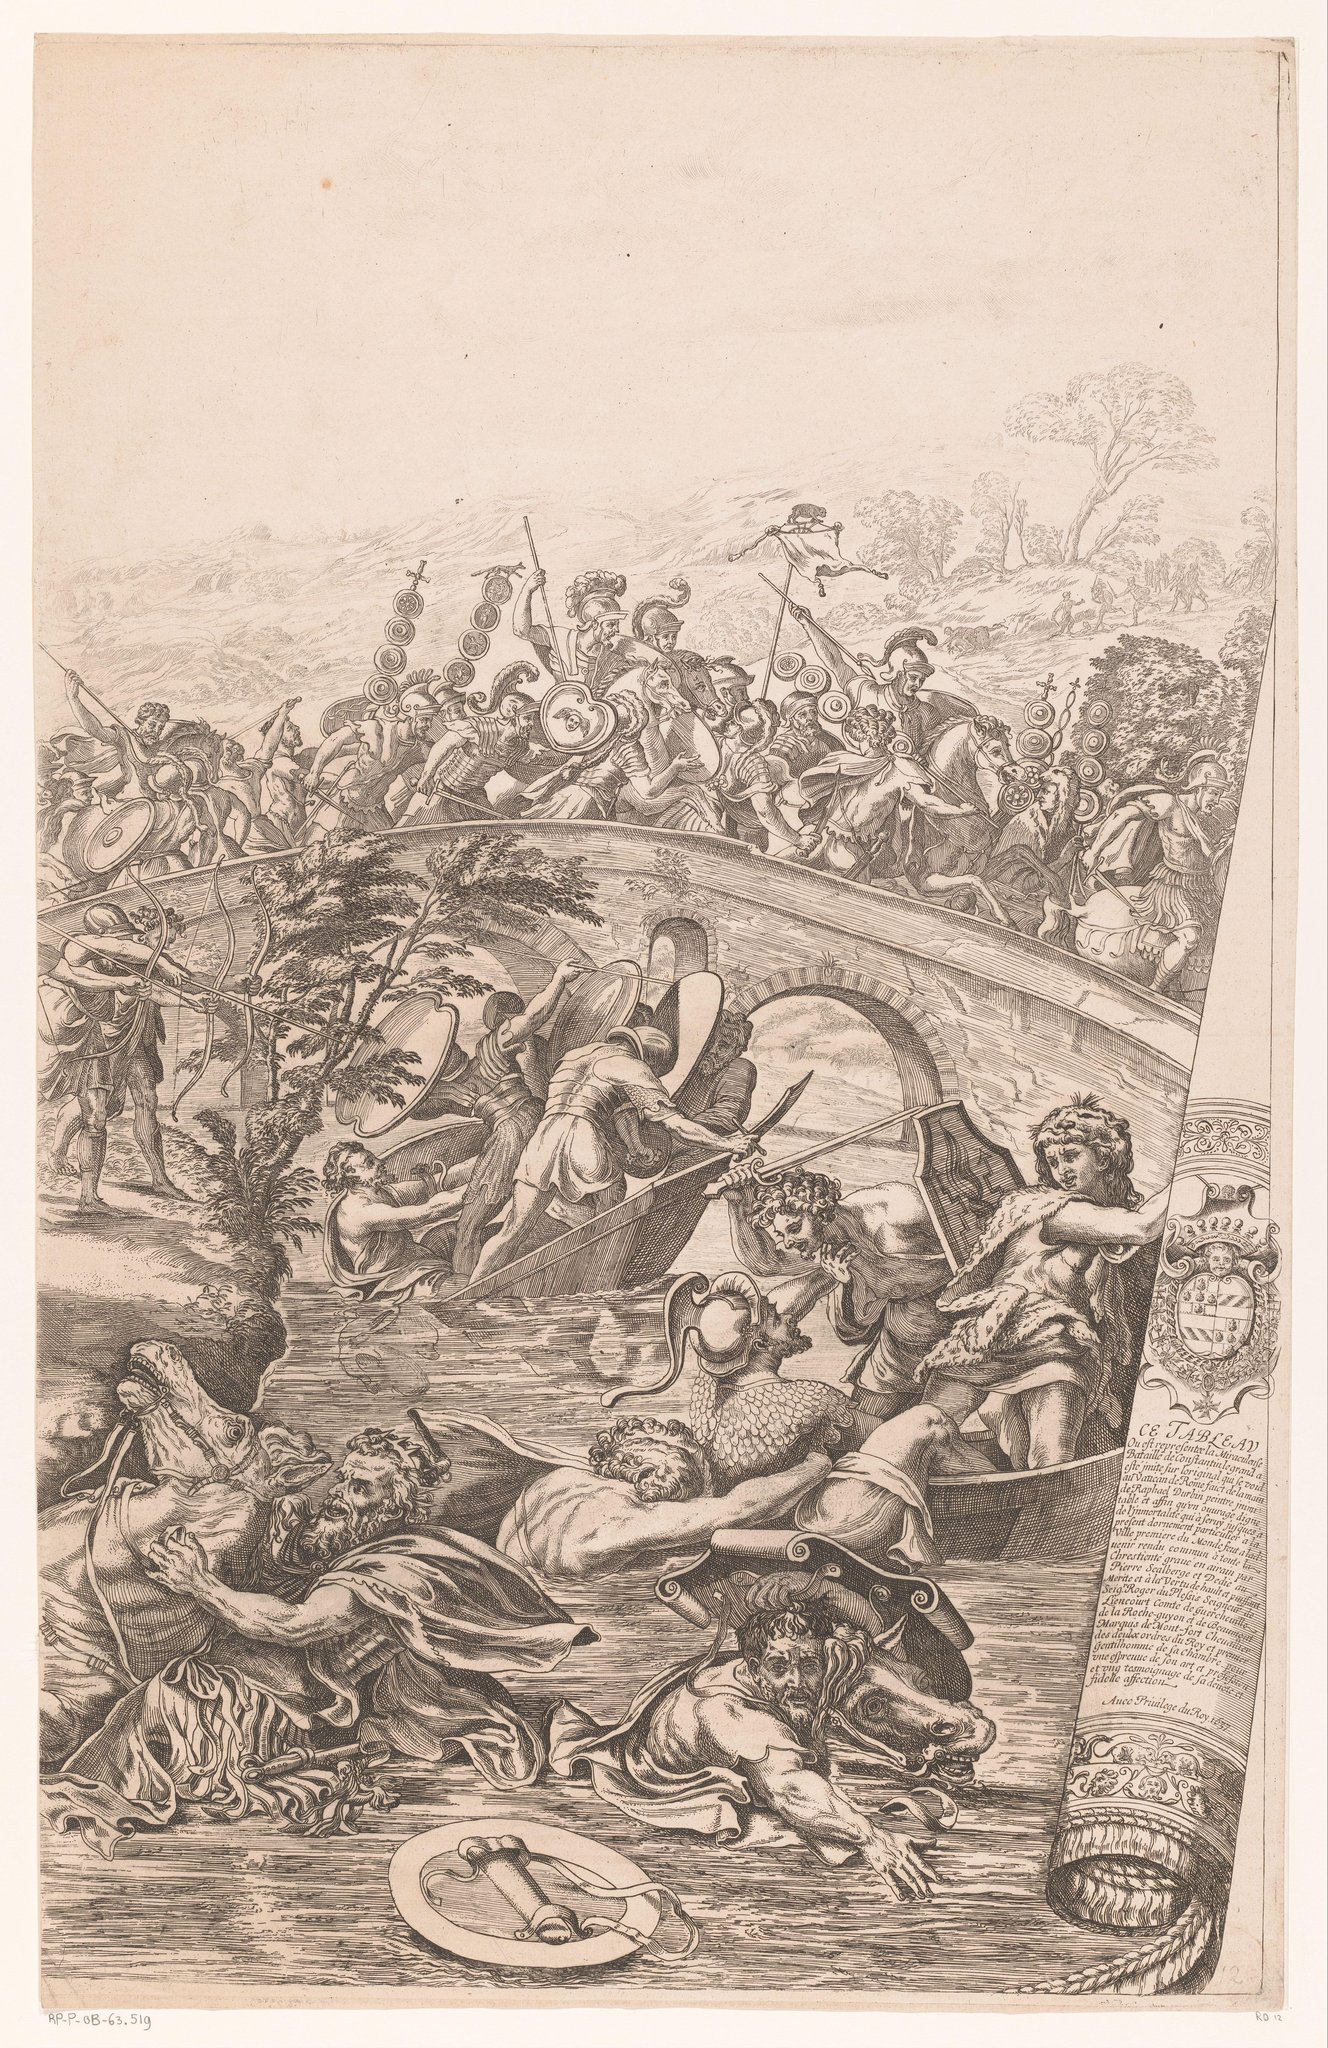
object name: print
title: Slag bij de Milvische brug (vierde deel)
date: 1637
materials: paper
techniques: etching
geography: france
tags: the battle of the milvian bridge (saxa rubra): st. constantine on horseback confronts maxentius; a cross appears in the sky with in fiery letters 'in hoc signo vinces' (the raised standards of the roman soldiers carry a cross or the chi-rho monogram)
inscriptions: collector's mark: Lugt 240